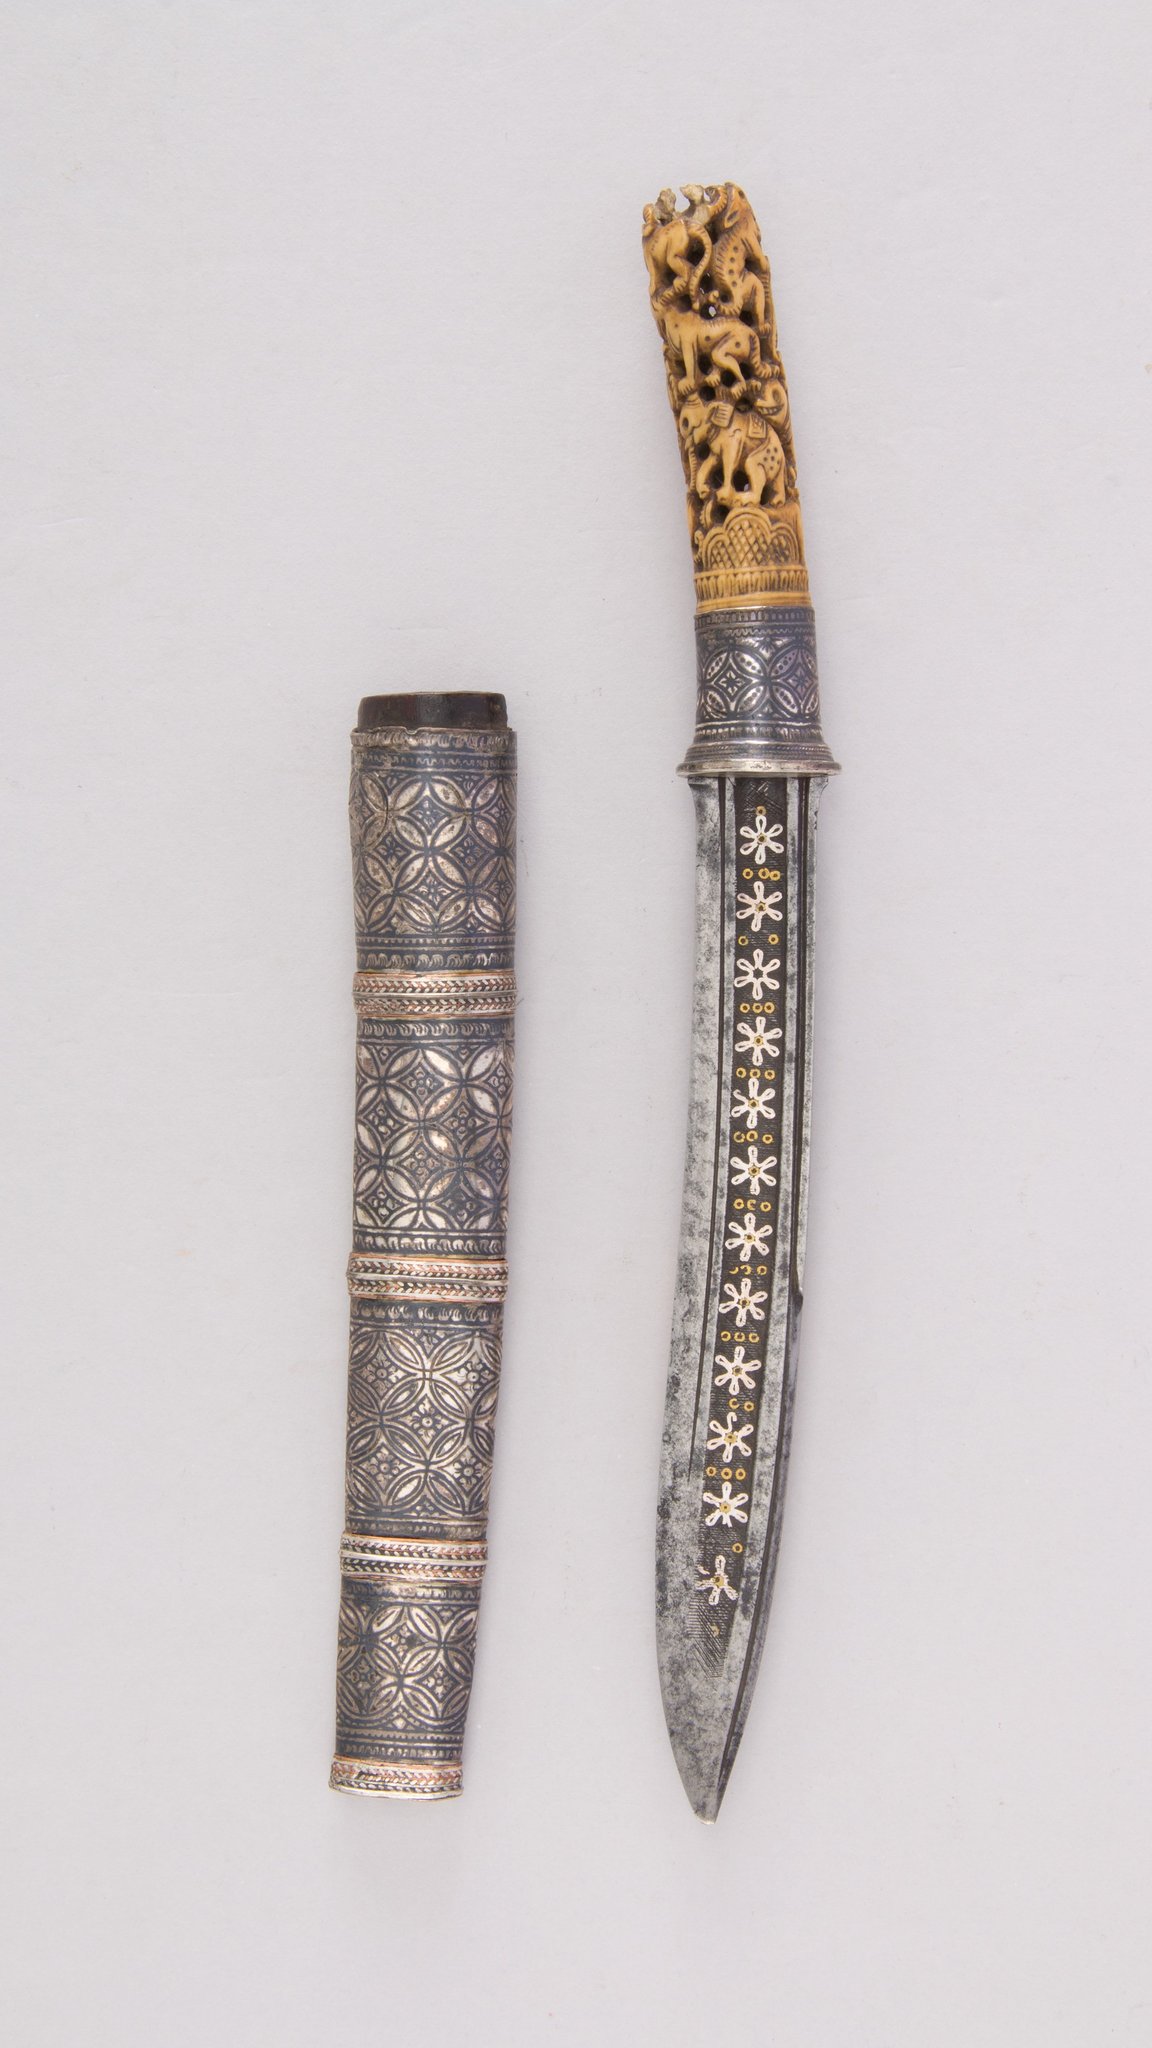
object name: dagger with sheath dah hmyaung or dha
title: Dagger with Sheath (Dah Hmyaung or Dha)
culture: burmese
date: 1701-1800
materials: copper, gold, ivory, silver, steel, wood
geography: myanmar